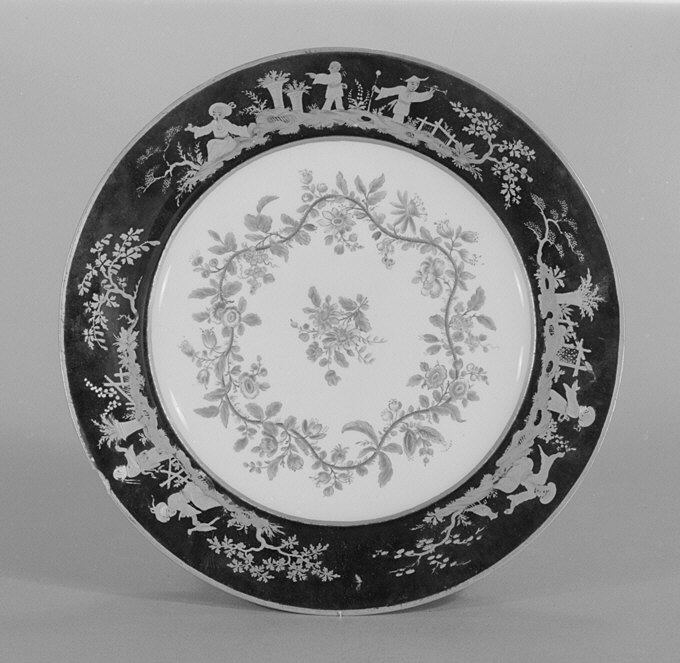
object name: plate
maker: sèvres manufactory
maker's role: manufactory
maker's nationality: french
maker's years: 1740-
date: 1791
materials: hard paste porcelain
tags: flowers